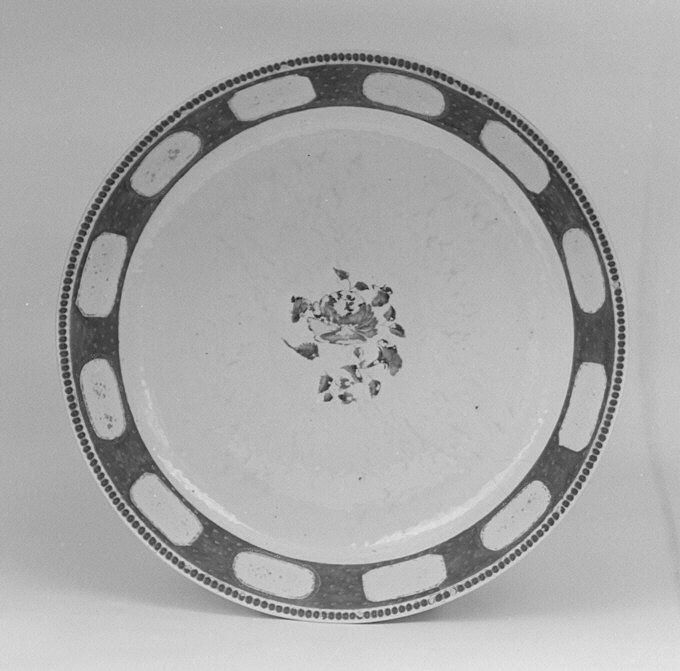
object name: chop plate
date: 1790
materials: hard paste porcelain